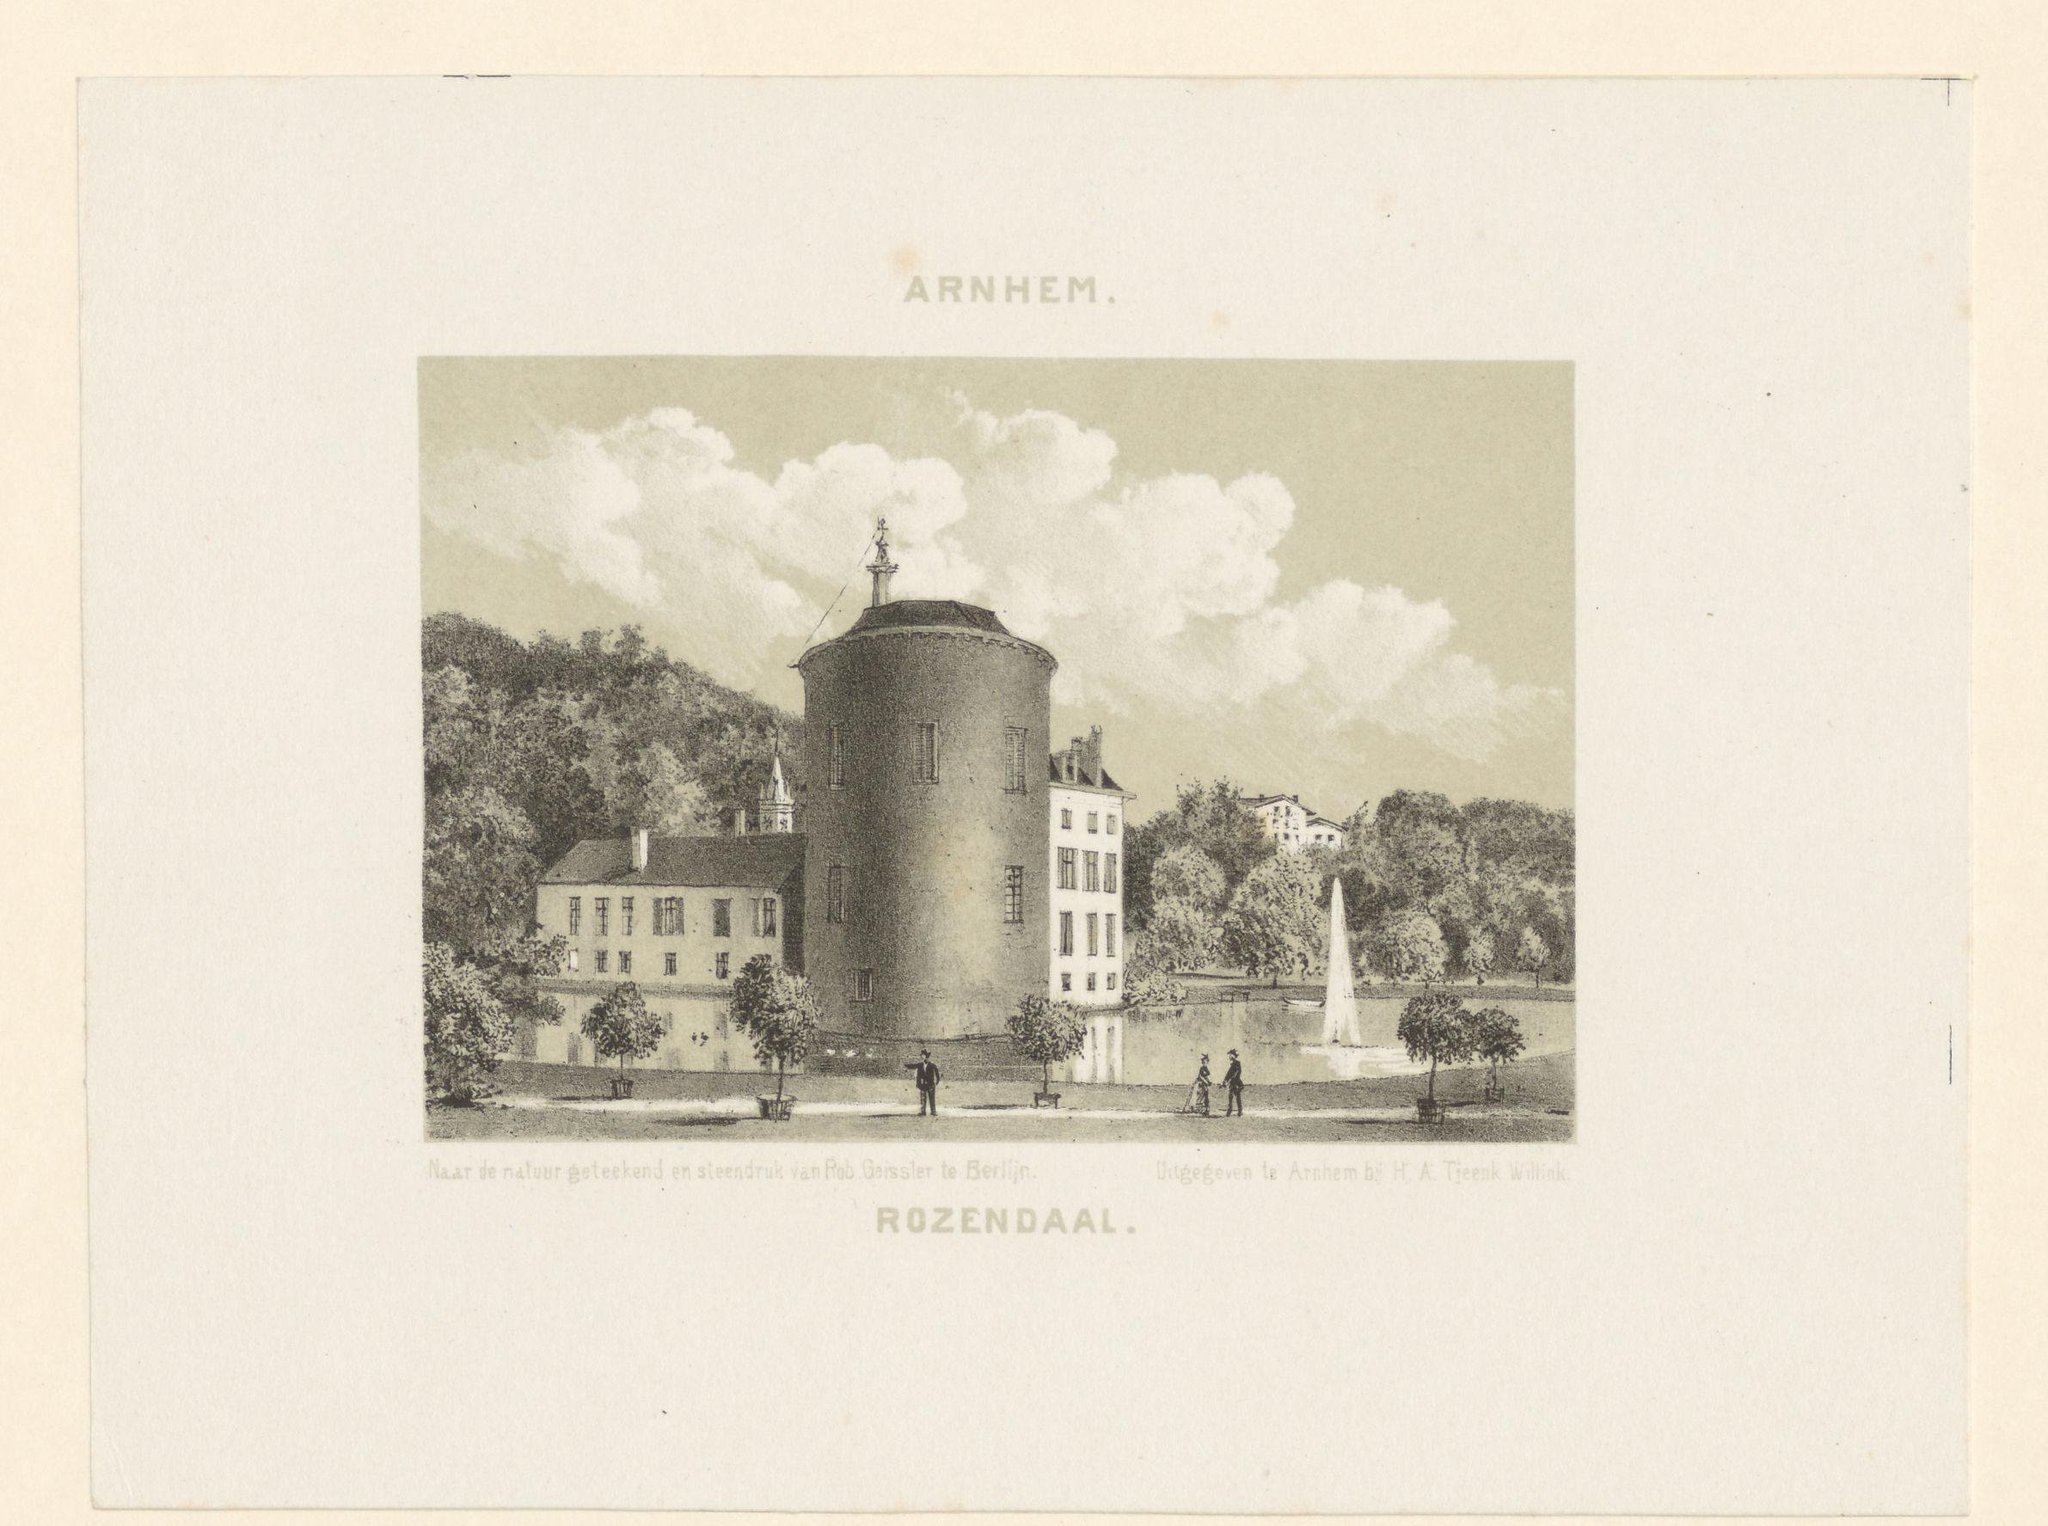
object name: print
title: Rozendaal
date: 1865-1875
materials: paper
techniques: tone lithography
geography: arnhem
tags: castle, arnhem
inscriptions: collector's mark: Lugt 2228